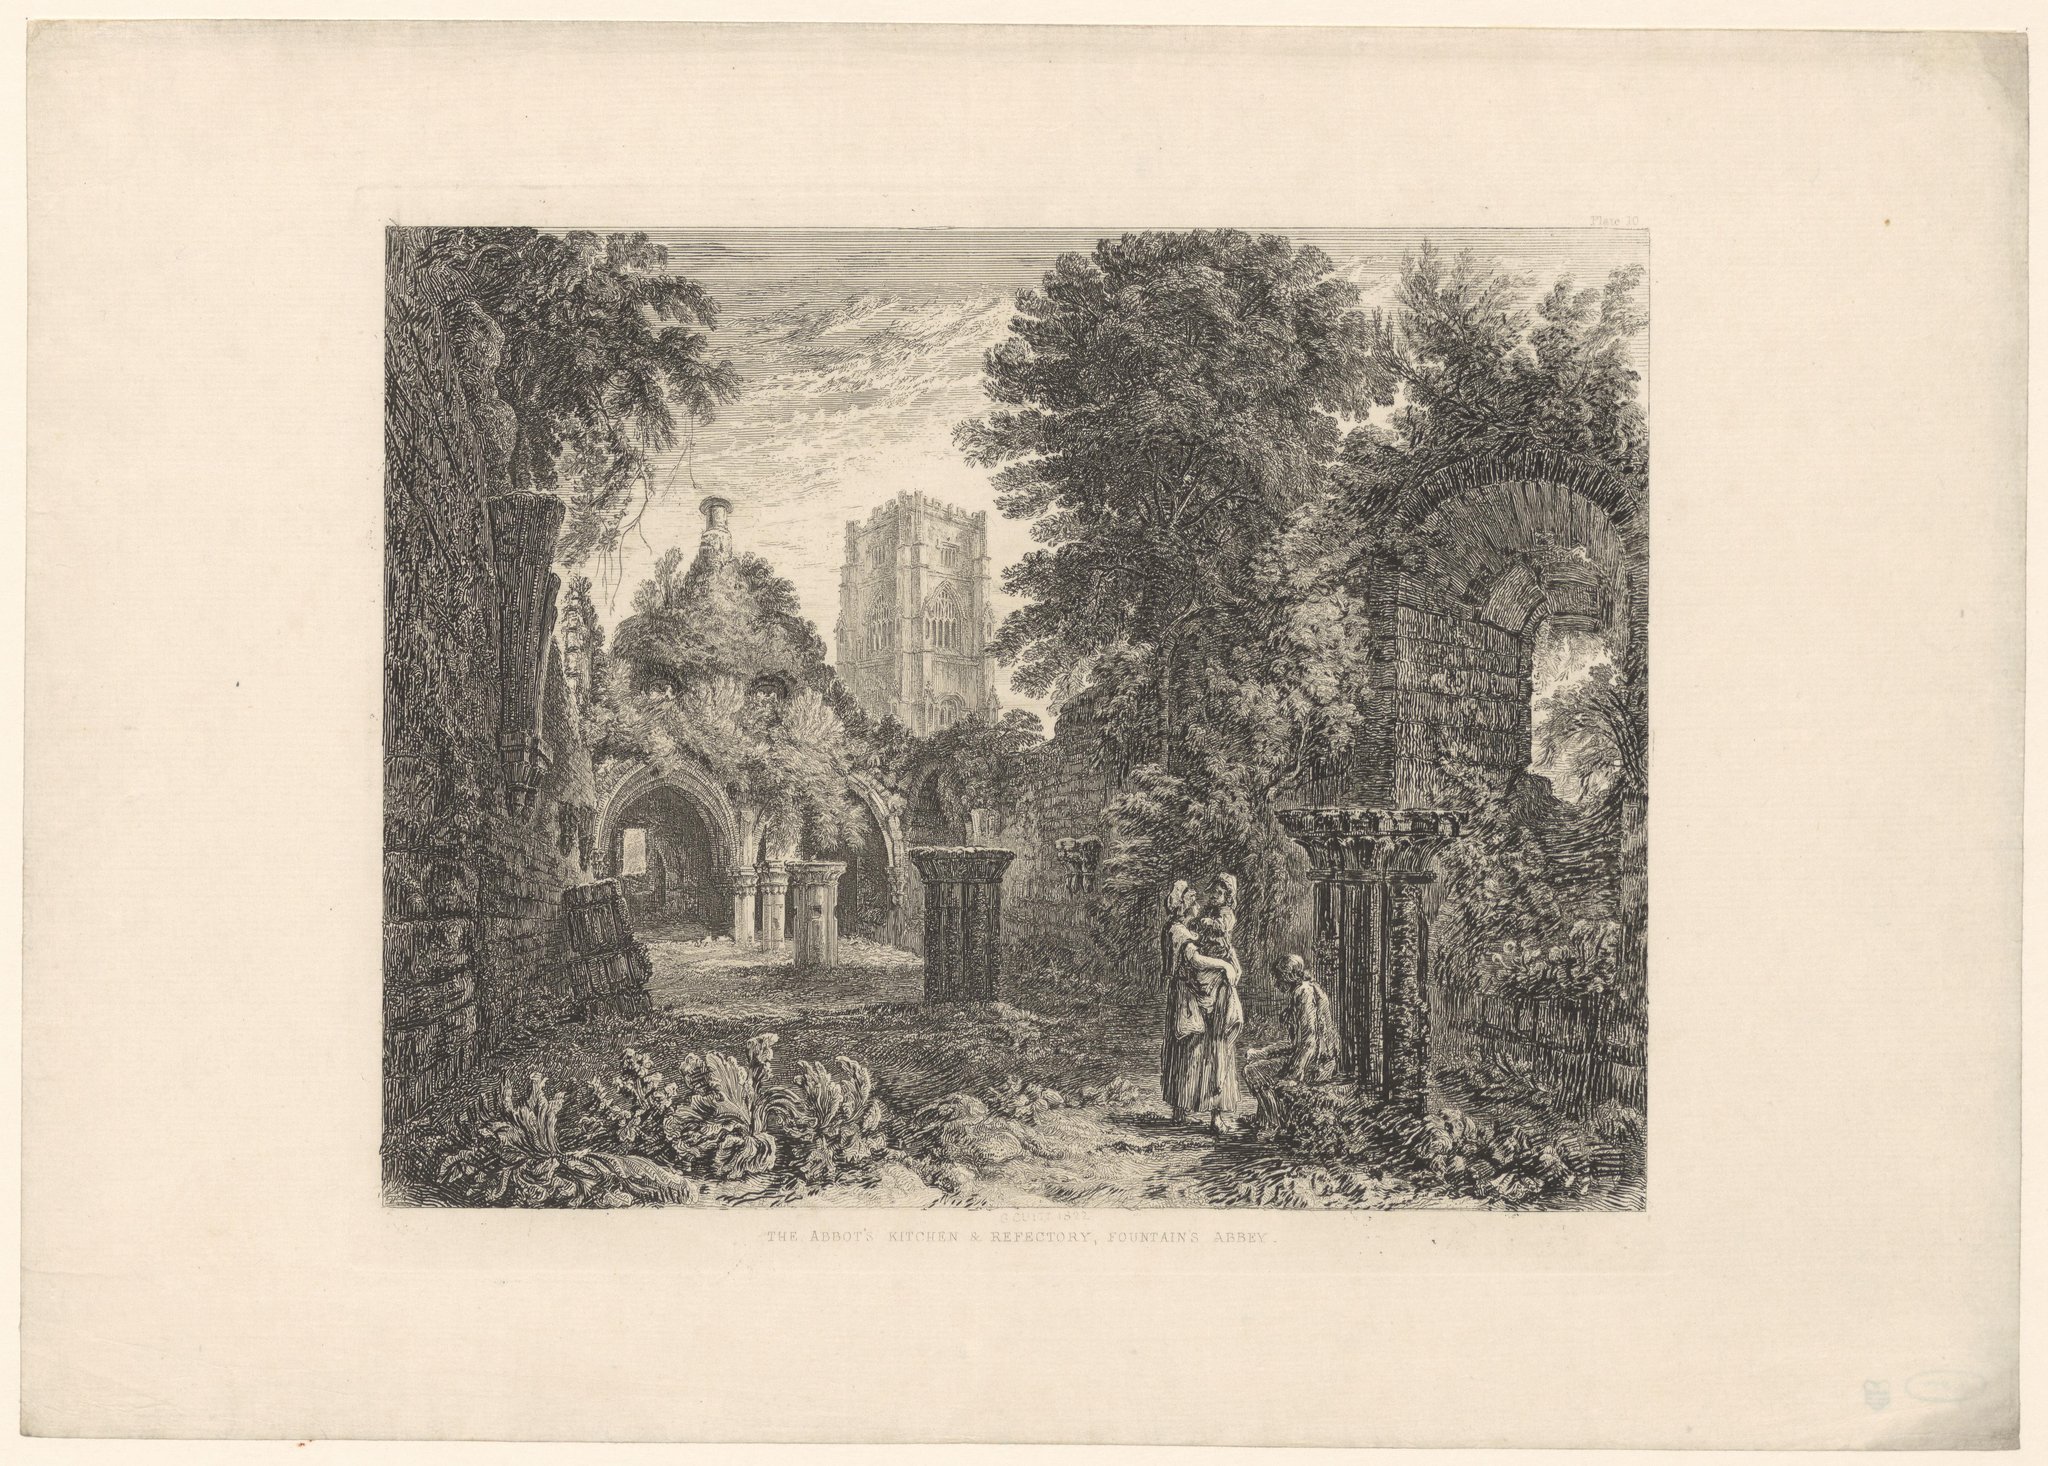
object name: print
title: The Abbot's Kitchen & Refectory, Fountain's Abbey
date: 1822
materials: paper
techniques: etching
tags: abbey garden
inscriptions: collector's mark: Lugt 2760, collector's mark: Lugt 2228